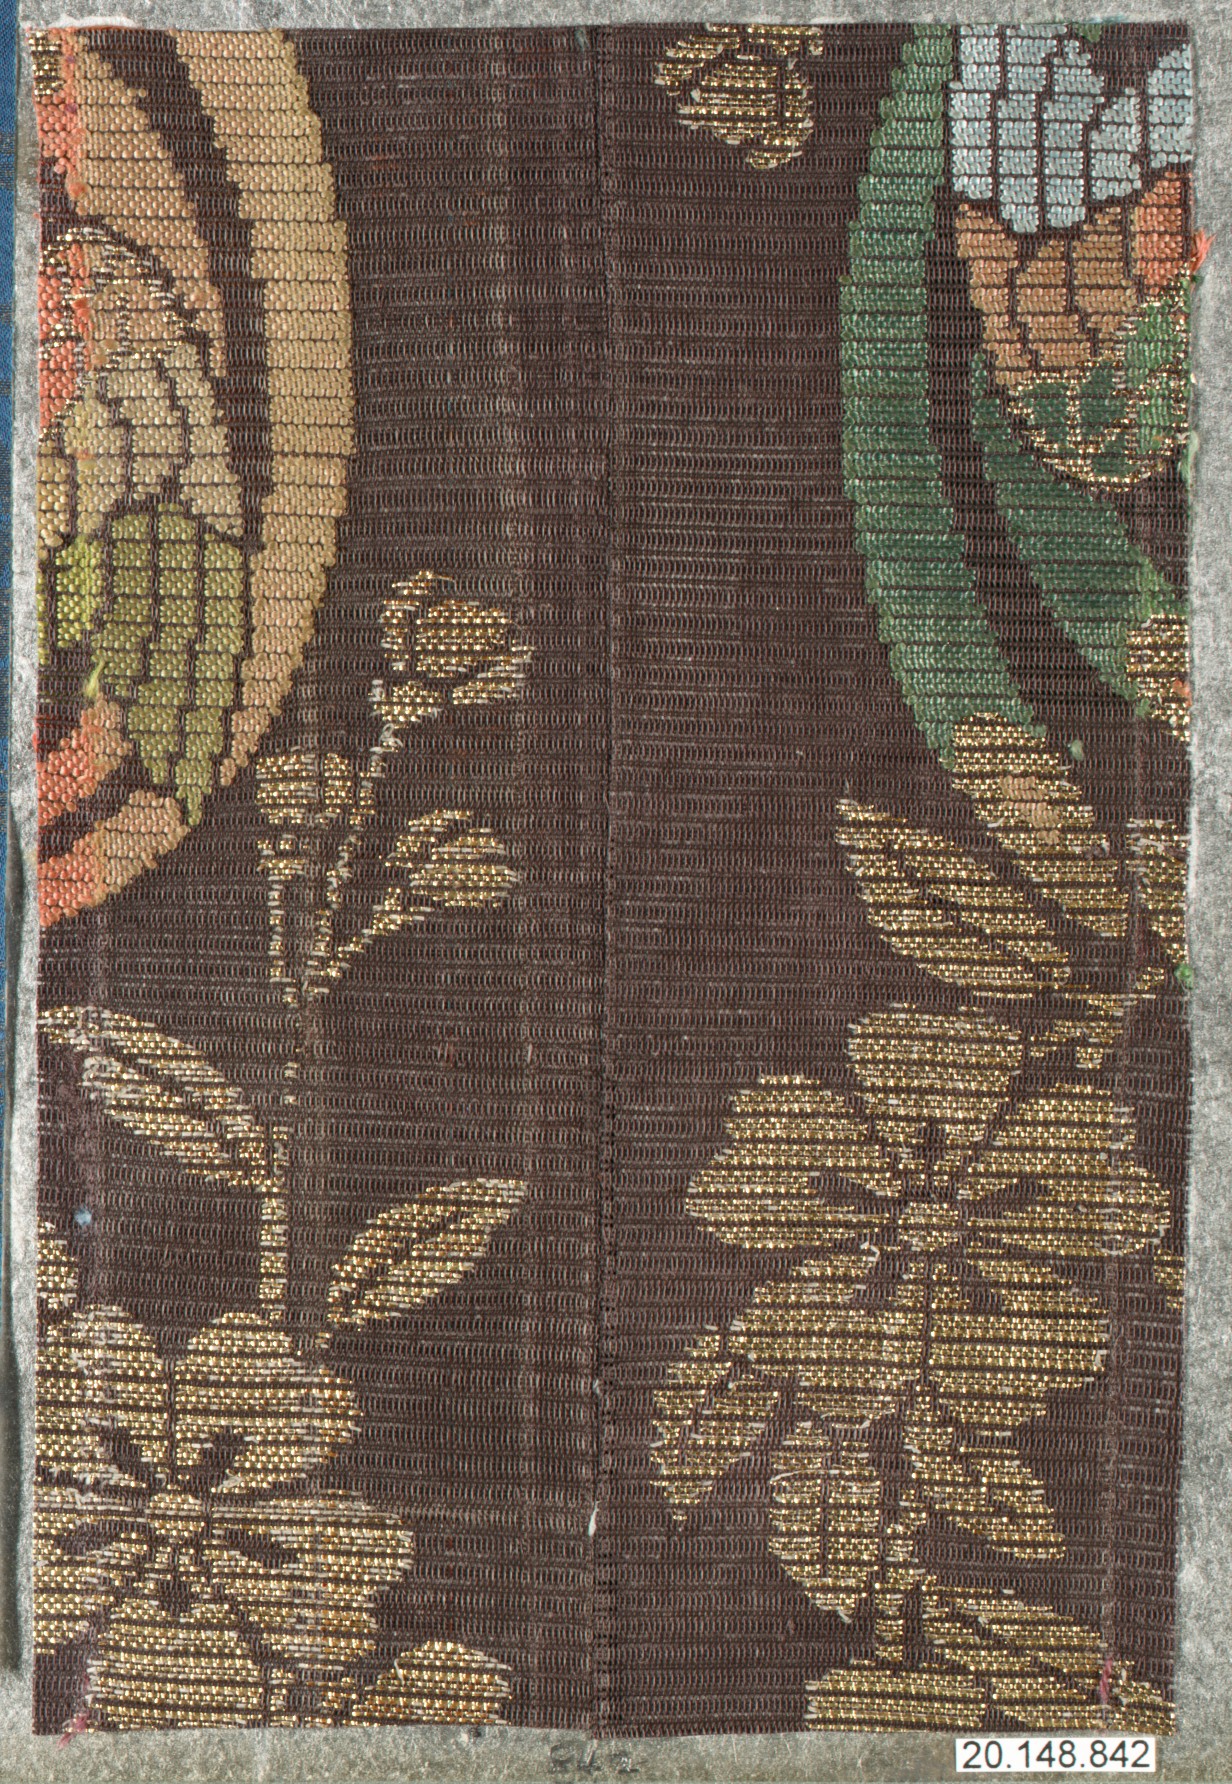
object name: piece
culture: china or japan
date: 1601-1700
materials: silk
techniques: compound weave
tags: flowers,leaves